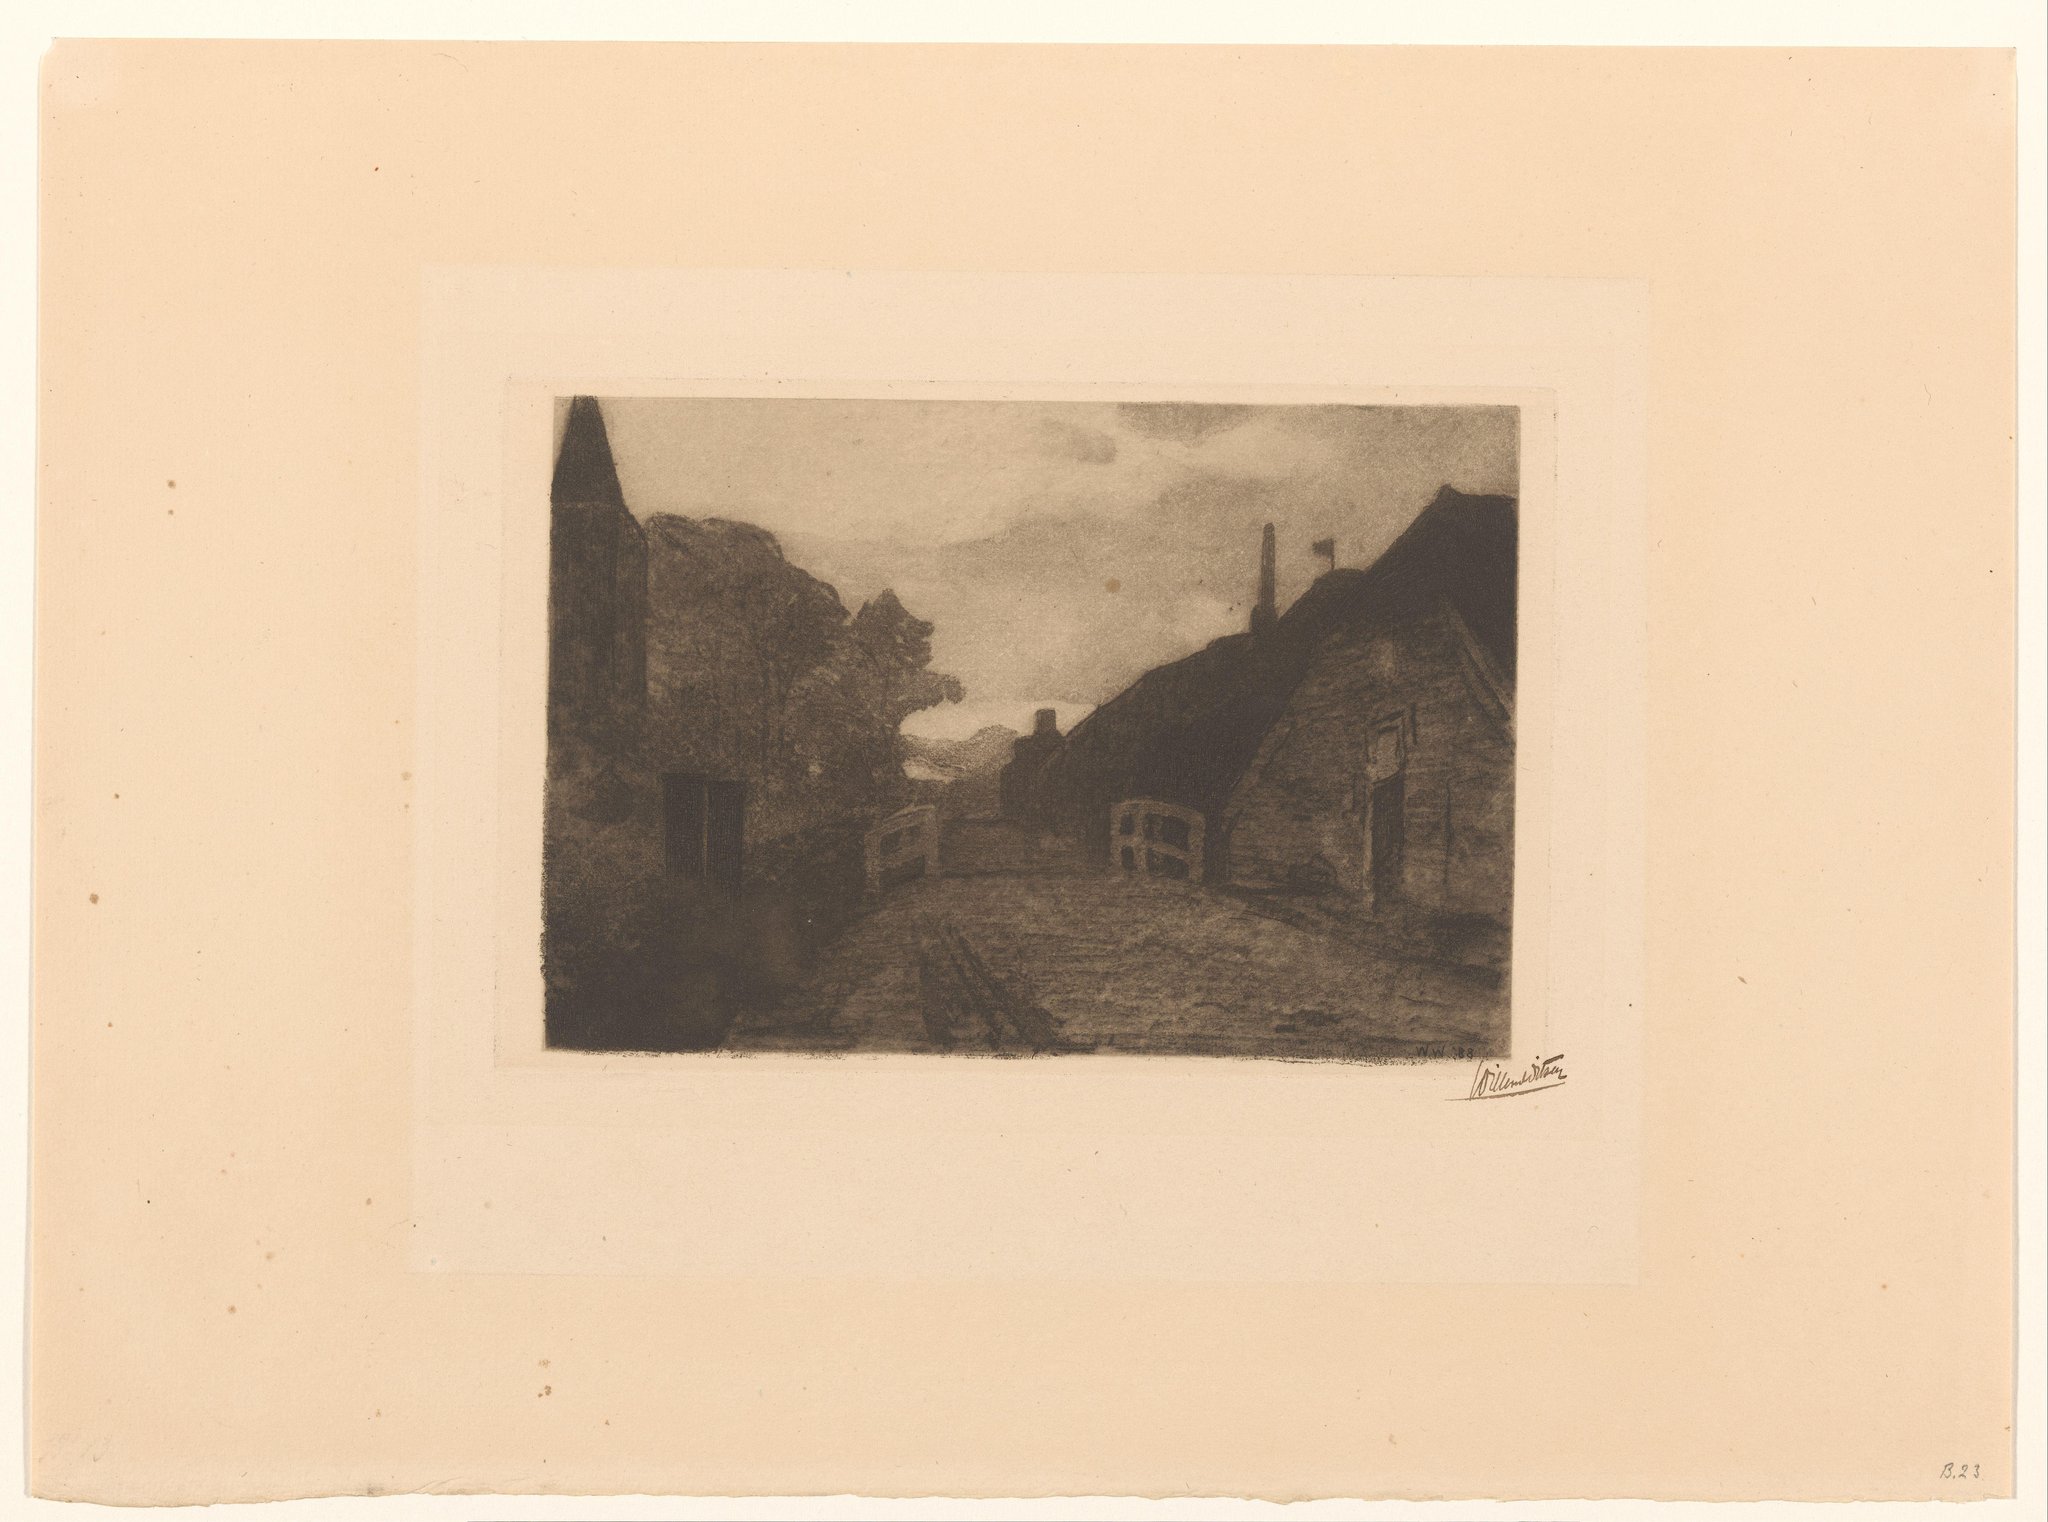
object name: print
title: Dorpsweg in Diepenheim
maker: willem witsen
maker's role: draughtsman, painter, print maker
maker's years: 1860-1923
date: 1888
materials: paper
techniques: etching, intaglio, soft ground etching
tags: tower, clock tower ~ monumental adornment, public road in village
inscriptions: watermark, collector's mark: Lugt 2228, signature: ‘Willem Witsen’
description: Volgens Witsens eigen opgave zijn er enkele exemplaren gedrukt door drukker Bouwens in Brussel.